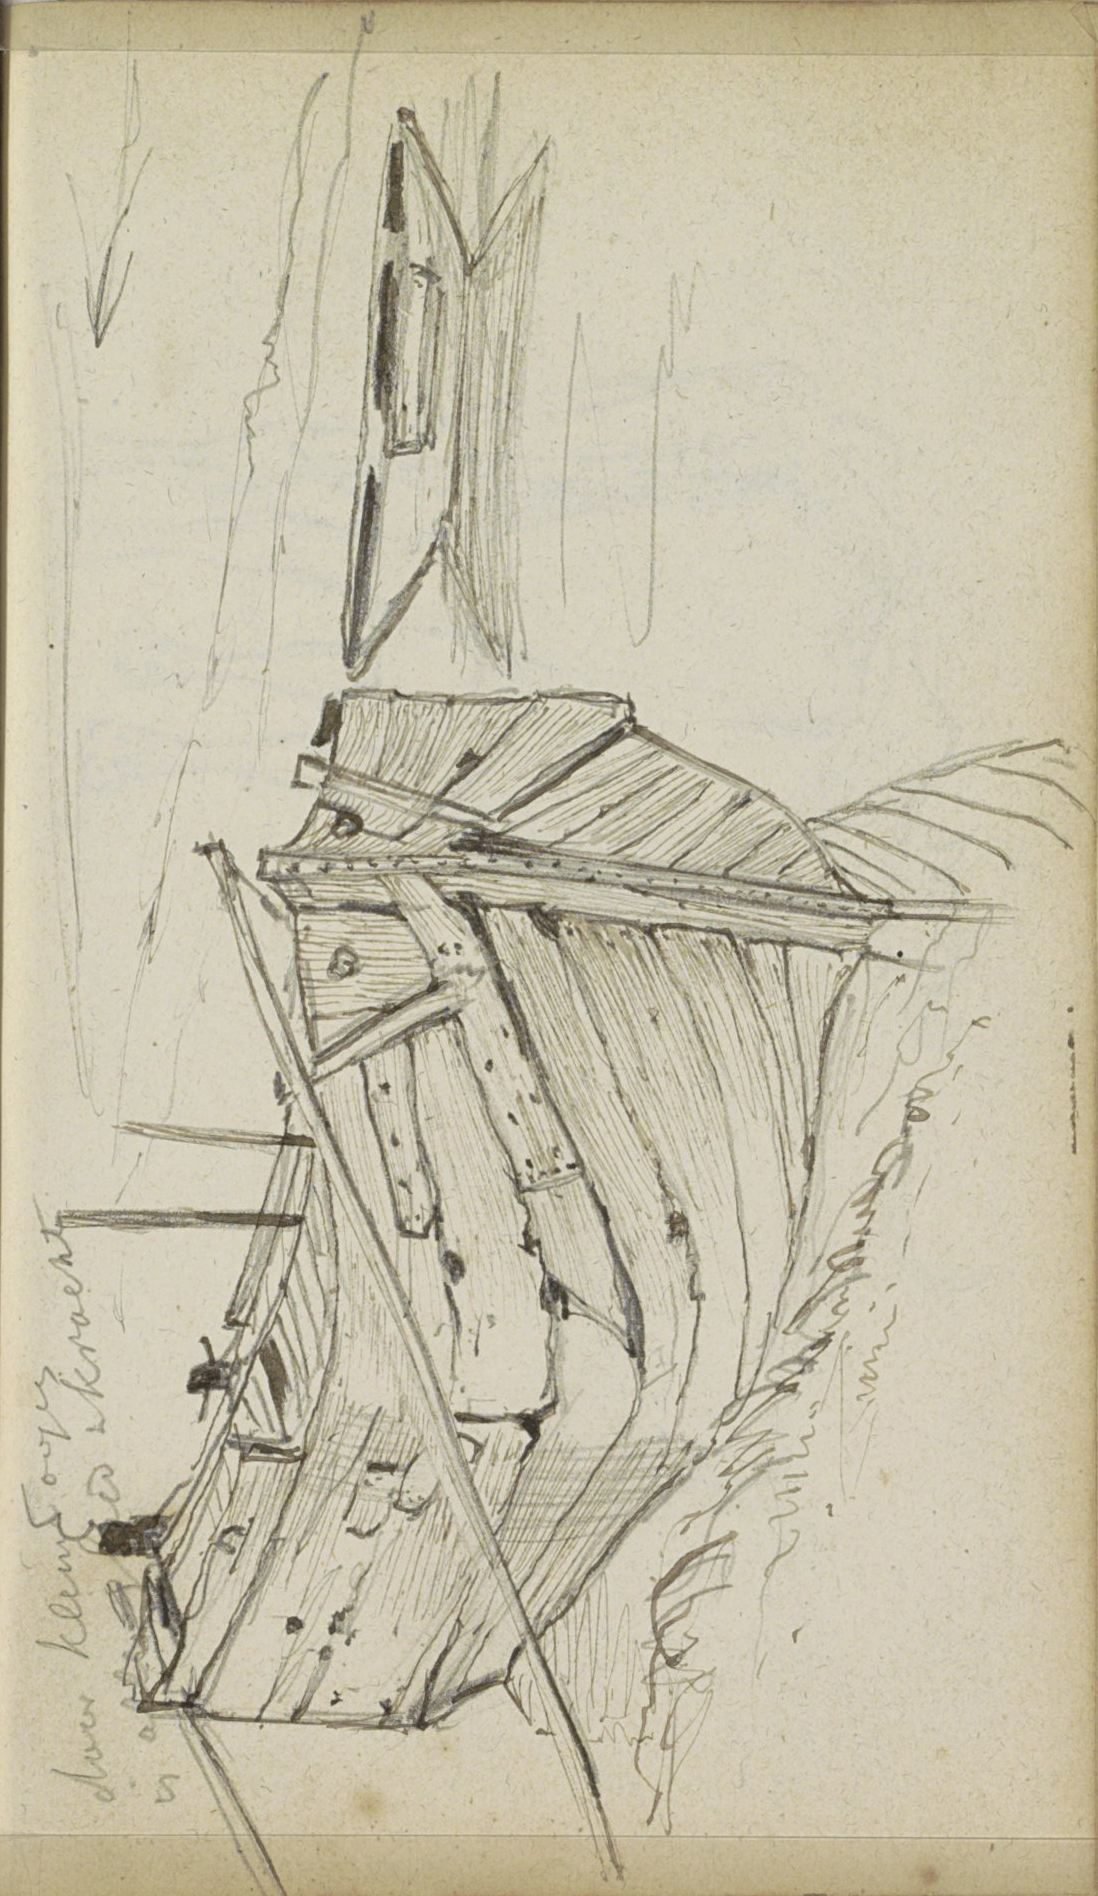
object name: sketchbook leaf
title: Roeiboot aan de waterkant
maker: johannes tavenraat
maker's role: draughtsman, painter, print maker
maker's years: 1809-1881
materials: ink, paper, pencil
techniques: pen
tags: river bank, rowing-boat, canoe, etc.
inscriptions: kleurnotitie, handgeschreven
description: Op de achtergrond een tweede roeiboot op het water. Blad 54 recto uit een schetsboek met 88 bladen.